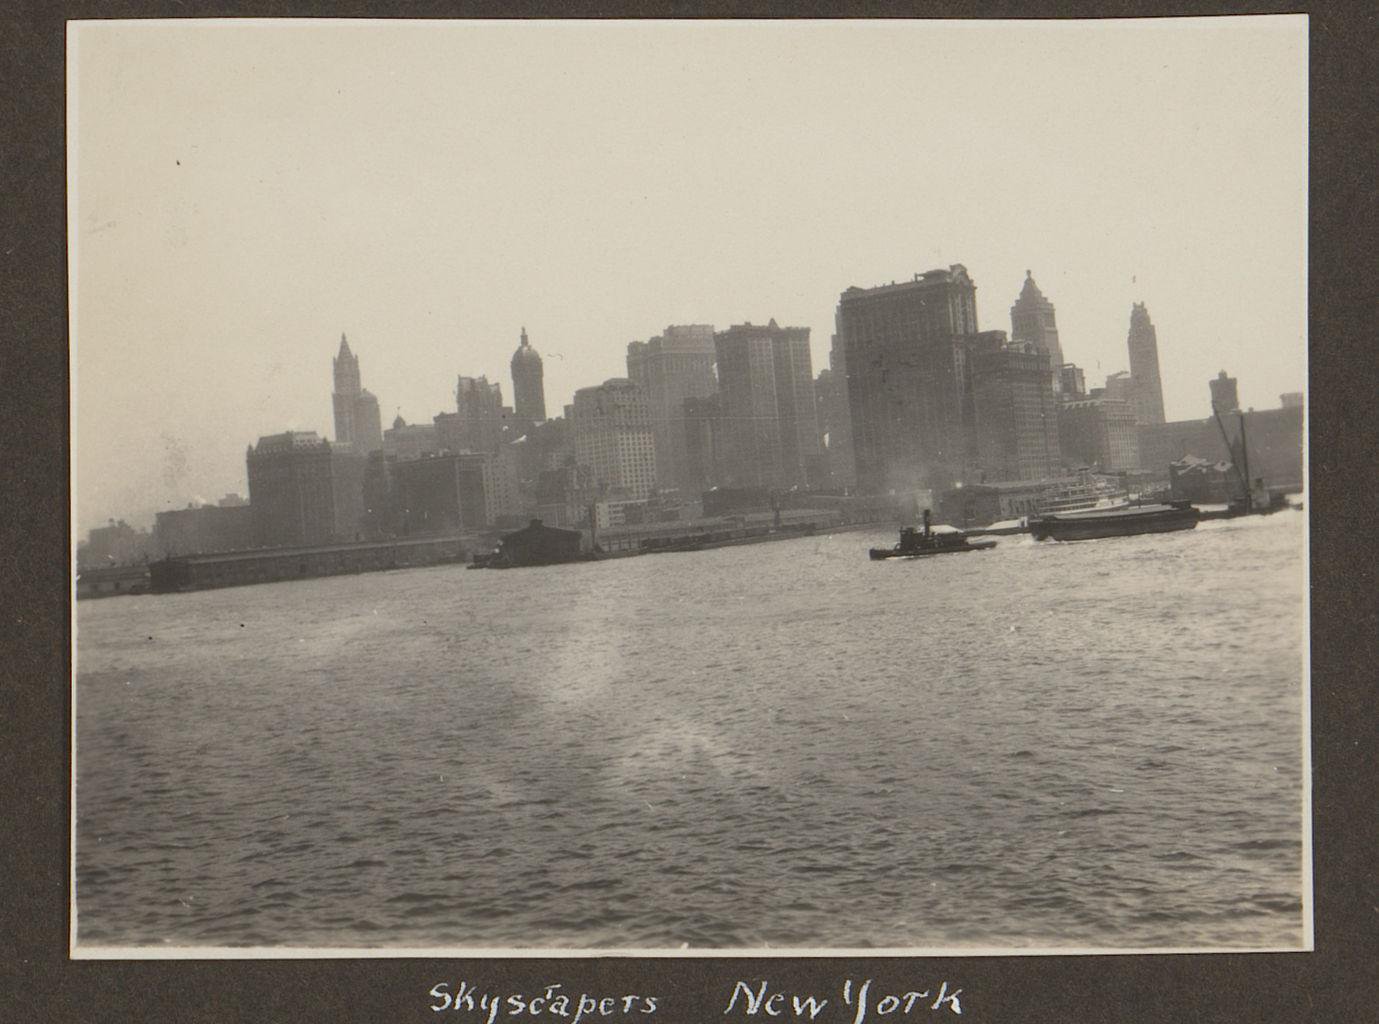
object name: photograph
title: Skyline van New York gezien vanaf het water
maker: Anonymous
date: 1928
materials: photographic support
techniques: gelatin silver print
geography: new york city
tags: skyscraper, river, prospect of city, town panorama, silhouette of city, new york (city)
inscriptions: annotation: ‘Skyscrapers New York/ Haven New York. Hoboken’